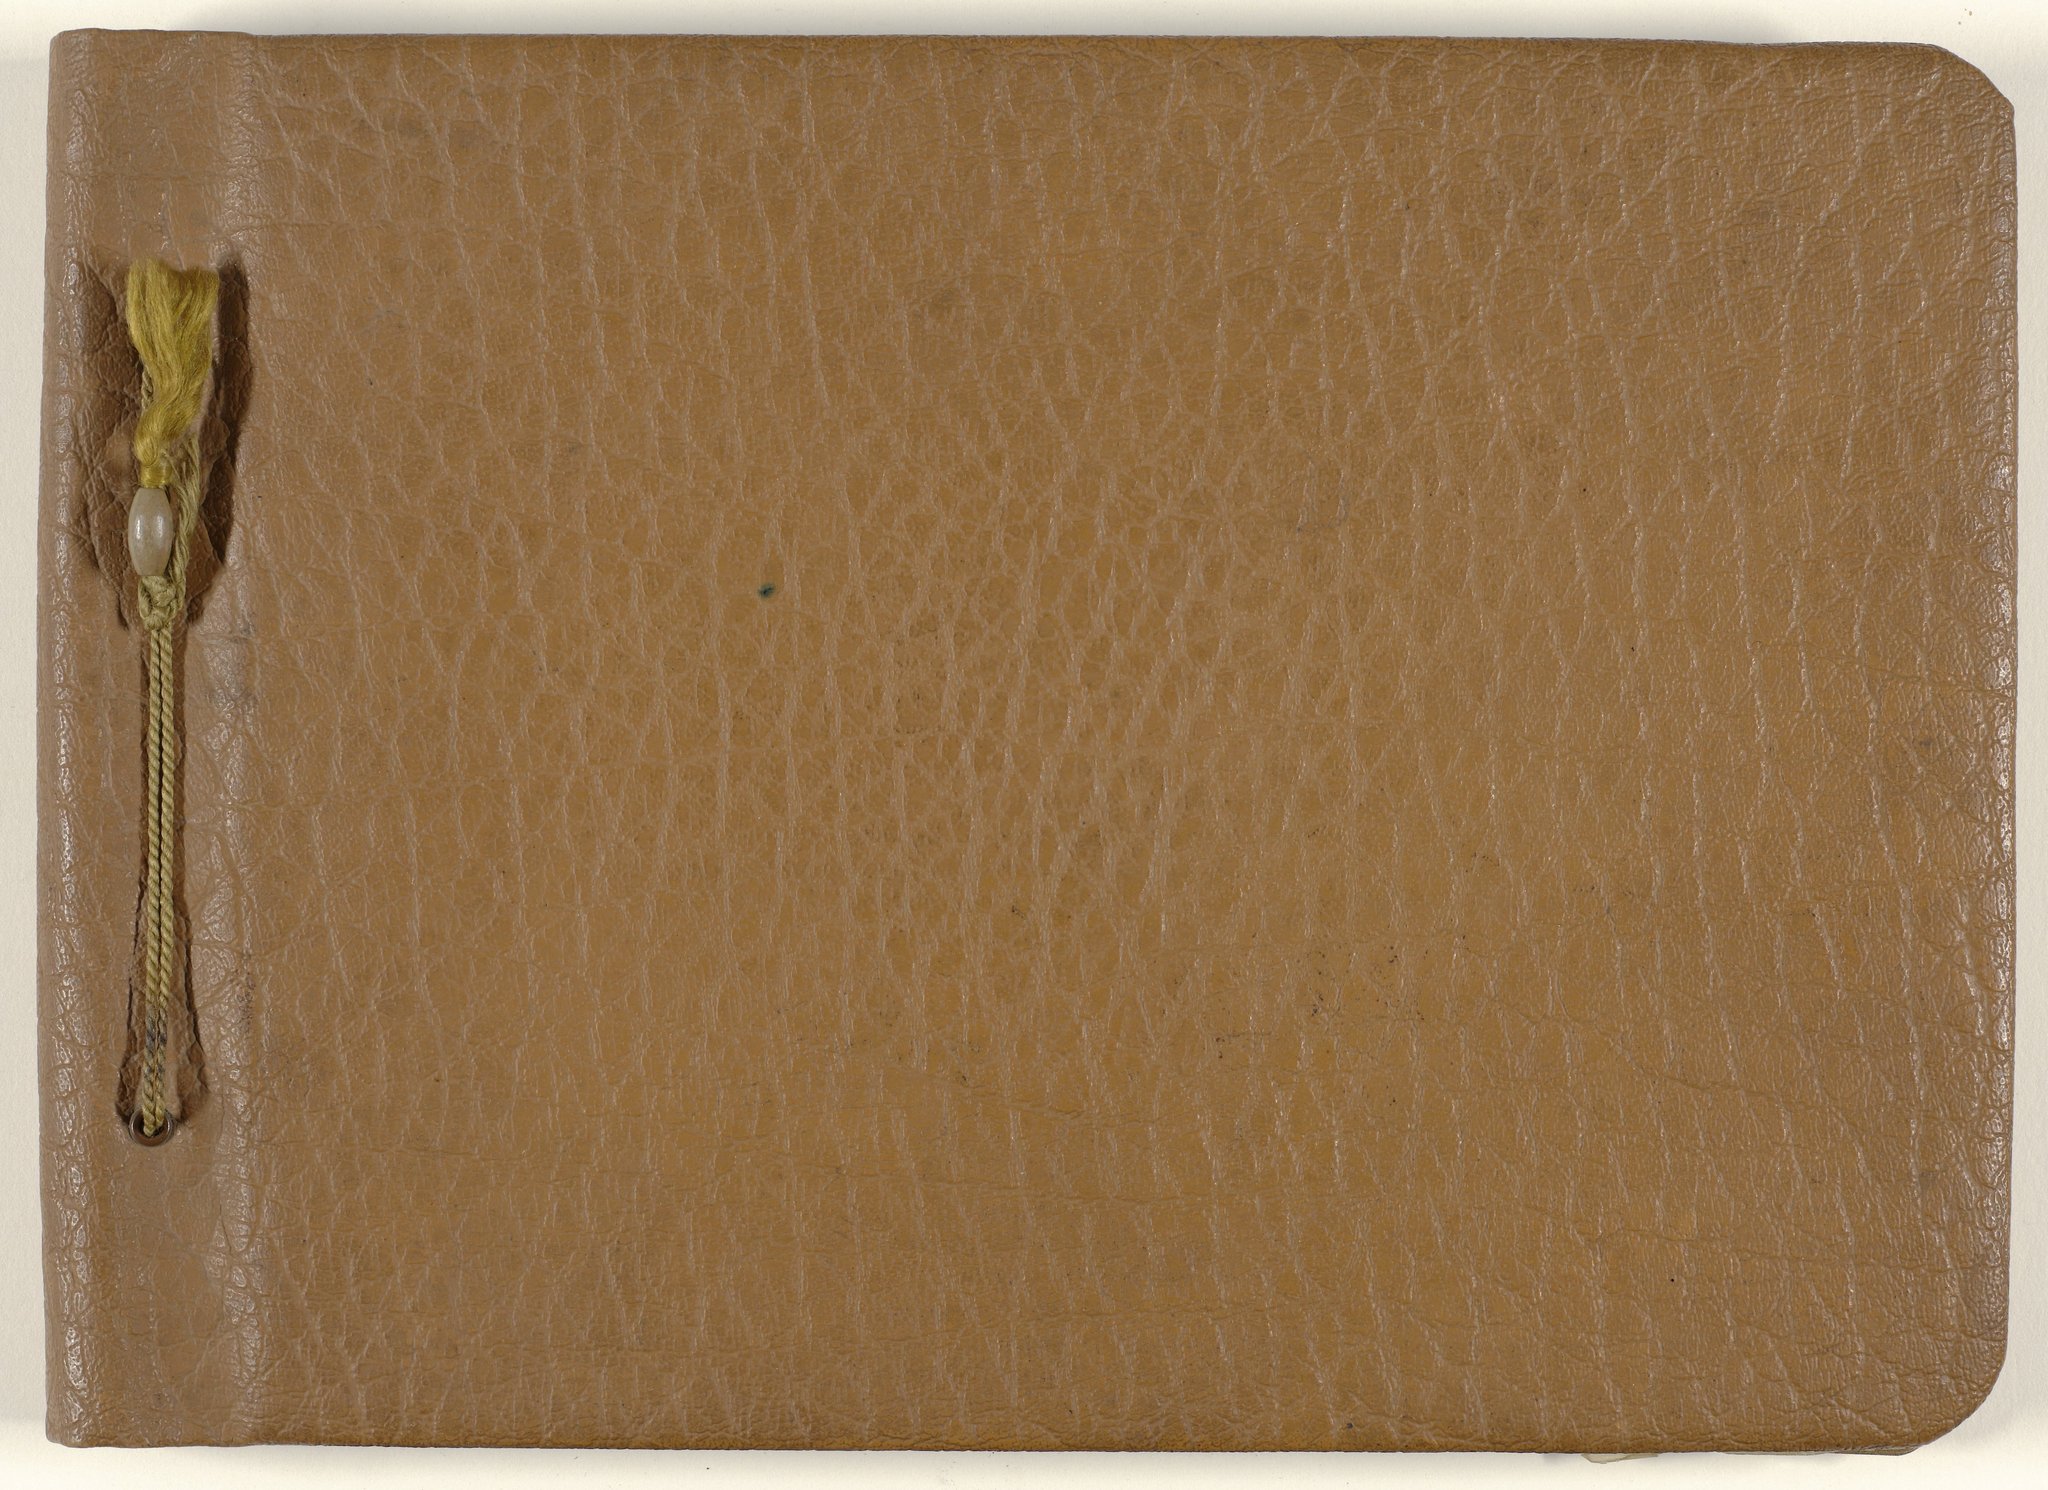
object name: photograph album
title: Fotoalbum van de Tijgerbrigade op Midden-Java, 1947-1950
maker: Anonymous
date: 1947-1950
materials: leather, paper, photographic support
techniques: photography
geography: dutch east indies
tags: dutch east indies, the, surabaya, indonesia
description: Het album is vermoedelijk eigendom geweest van sergeant Jan Visser. De foto's zijn waarschijnlijk voor een klein deel door hem zelf gemaakt, maar voor het grootste deel door een verpleger, Leo Kaper genaamd. Hij reisde mee met de compagnie en maakte foto's. Volgens één van de leden van de compagnie, verteld tijdens de veteranenreünie van 2-5-5- RI op 13 mei 2009, stuurde Kaper de negatieven op naar Nederland. Hier liet hij ze ontwikkelen om vervolgens weer terug gestuurd te worden naar Indië, zodat de soldaten ter plekke de foto's konden nabestellen. [info afkomstig uit stageverslag van Marleen Kers, stagaire afdeling Geschiedenis Rijksmuseum, 4 mei 2009]. Het tweede bataljon van het vijfde Regiment Infanterie, ook wel 2de Cie of 2-5-5 RI genoemd was onderdeel van de Tijgerbrigade en werd vlak voor tweede militaire actie op Midden-Java ingezet. Tijdens deze tweede militaire actie werd op 21 december 1948 Jogykarta binnen getrokken. Al snel daarna kreeg het bataljon de opdracht om de opmars naar Magelang voort te zetten waar zij op 23 december de bezetting over namen. Voor de actie ‘Zuid’ werd het bataljon op 12 en 13 januari 1949 opnieuw overgeplaatst naar Jogyakarta en Sentolo, waarna ze op 18 januari de opdracht kregen om het gebied ten zuiden van Jogyakarta te 'zuiveren'. Na deze actie had het bataljon posten te Sentolo, Barongan en Bantoel. Op 18 maart 1949 werd het bataljon gelegerd in het district Wonosari, waar het tot de ontruiming van Jogyakarta, op 29 juni 1949, gelegerd is geweest. Vanaf 1 juli volgden Klaten en Koedoes, waar de bezette gebieden werden overgedragen aan de TNI. Uiteindelijk op 20 maart 1950 werd het bataljon in afwachting van de repatriëring gelegerd in Buitenzorg (koloniale naam voor de plaats Bogor, ten zuiden van Jakarta, West-Java). Het 5-5e Regiment Infanterie is opgericht op de 1e Juli 1947 in Schalkhaar en bestond uit dienstplichtigen van het jaar 1947. Het vertrok aan boord van “het Zuiderkruis” op 17 december 1947 naar Nederlands-Indië en kwam op 16 Januari 1948 aan in Semarang. Meteen na aankomst werd de 4e compagnie overgeplaatst naar het 5-13e Regiment Infanterie in Cheribon, waar het maar voor een maand bestond. Daarna werd de 4e compagnie verdeeld over andere bataljons op Java. Het 5-5e Regiment Infanterie was gelegerd rond Salatiga bij het 2-6e Regiment Infanterie en het 2-7e Regiment Infanterie. Op 9 April 1948 nam het 5-5e Regiment Infanterie de posten over van het 2-6e Regiment Infanterie in Kopeng, Karangdoeren, Setoegoer, Dadapajam en Reksosari. Op 5 November 1948 werd het 5-5e Regiment Infanterie afgelost door het 411e Bataljon Infanterie en werd gelegerd in Dadapajam, Reksosari en Telogo. Tijdens de tweede militaire actie op 19 December 1948 trok het 5-5e Regiment Infanterie over land naar Djocjacarta met uitzondering van de pioniers, zij vlogen samen met de commando’s naar Djocjacarta..Weer herenigd met de rest van het 5-5e Regiment Infanterie arriveerde het op 21 December 1948 in Djocjacarta. De dag daarop volgend op 22 December 1948 kreeg het 5-5e Regiment Infanterie orders om op te marcheren naar Magelang, wat door Infanterie V KNIL al was ingenomen. De bewaking van Magelang werd op 23 December 1948 overgenomen. Op 24 December 1949 veroverde het 5-5e Regiment Infanterie Temanggoeng en op 25 December 1948 Parakan. In aansluiting op de operatie “Zuid” werd het 5-5e Regiment Infanterie overgeplaatst naar Djocjacarta op 12 en 13 Januari 1949. Deze actie begon op 18 Januari 1948 en zuiverde het zuidelijk gebied rond Djocjacarta. Na deze actie betrok het 5-5e Regiment Infanterie posten in Sentolo, Barongan, Bantoel en Karangsemoet, maar na drie weken werden zij afgelost. Op 6 Maart 1949 werd de ondersteunings-compagnie van het 5e Garde Regiment Grenadiers overgeplaatst naar het 5-5e Regiment Infanterie en gelegerd in Kota Gedeh. Later werd de compagnie ontbonden en de manschappen werden verspreid over de rest van het 5-5e Regiment Infanterie. Op 16 Maart werden de posten in Sentolo, Barongan en Bantoel overgedragen aan het 5e Regiment Stoottroepen. 18 Maart 1949 werd het 5-5e Regiment Infanterie gelegerd in Djocjacarta waar het bleef tot de evacuatie van de stad op 29 Juni 1949. Op 1 Juli 1949 nam het 5-5 Regiment Infanterie de posten rond Klaten over van Infanterie I KNIL en het 4-9e Regiment Infanterie, maar ook in deze omgeving kreeg het geen rust. Nadat dit gebied was overgegeven aan de TNI verplaatste het 5-5e Regiment Infanterie zich naar Koedoes. Op 18 December 1949 werd het 5-5e Regiment Infanterie gelegerd in Oengarang waar het op 13 Maart 1950 door het 425e Bataljon Infanterie werd afgelost. De Grenadiers in Semarang werden teruggeplaatst naar hun eigen eenheid. En op 20 Maart 1950 werd het 5-5e Regiment Infanterie gelegerd in Buitenzorg waar het op hun repatriëring wachtte. Op 20 April 1950 verliet het 5-5e Regiment Infanterie aan boord van de “Nelly” Nederlands-Indië en arriveerde op 2 Mei 1950 in Nederland.